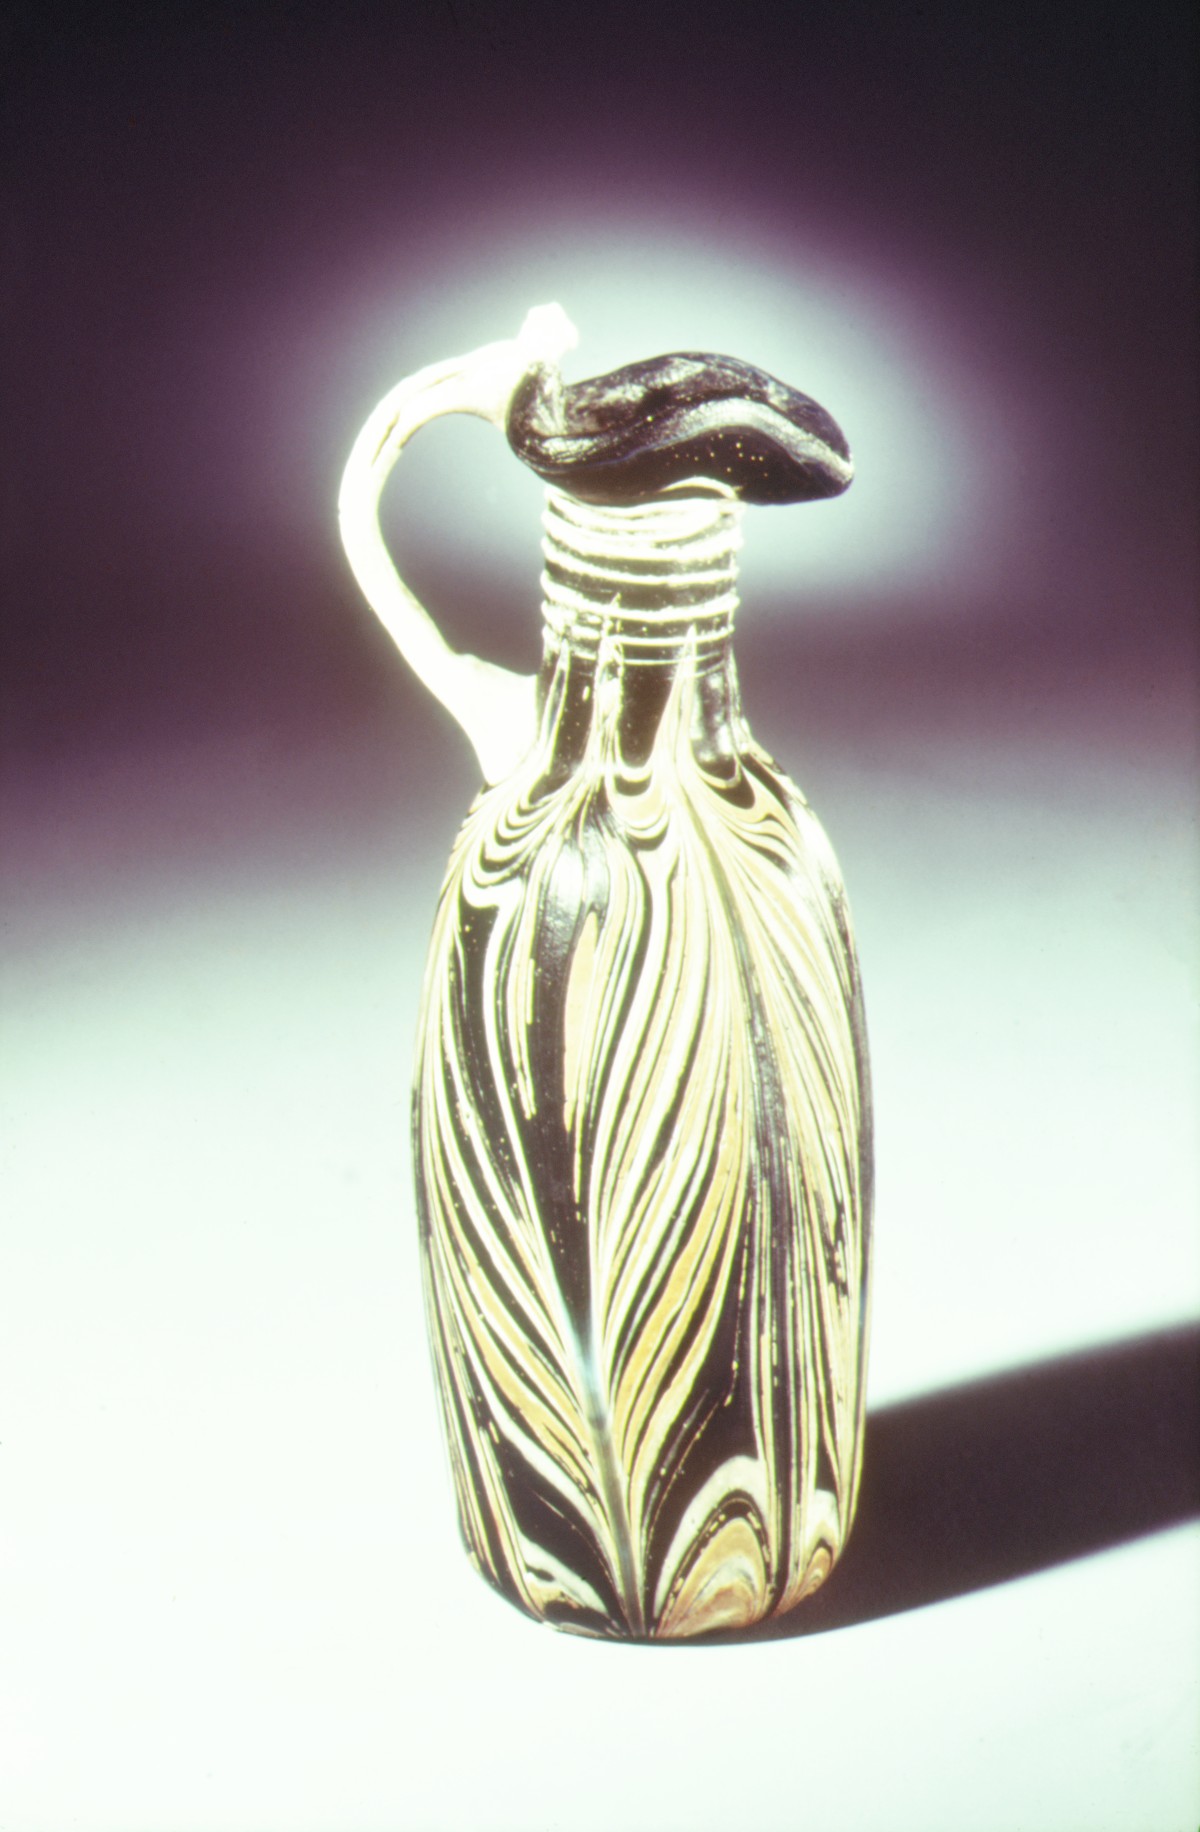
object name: ewer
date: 1801-1900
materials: glass